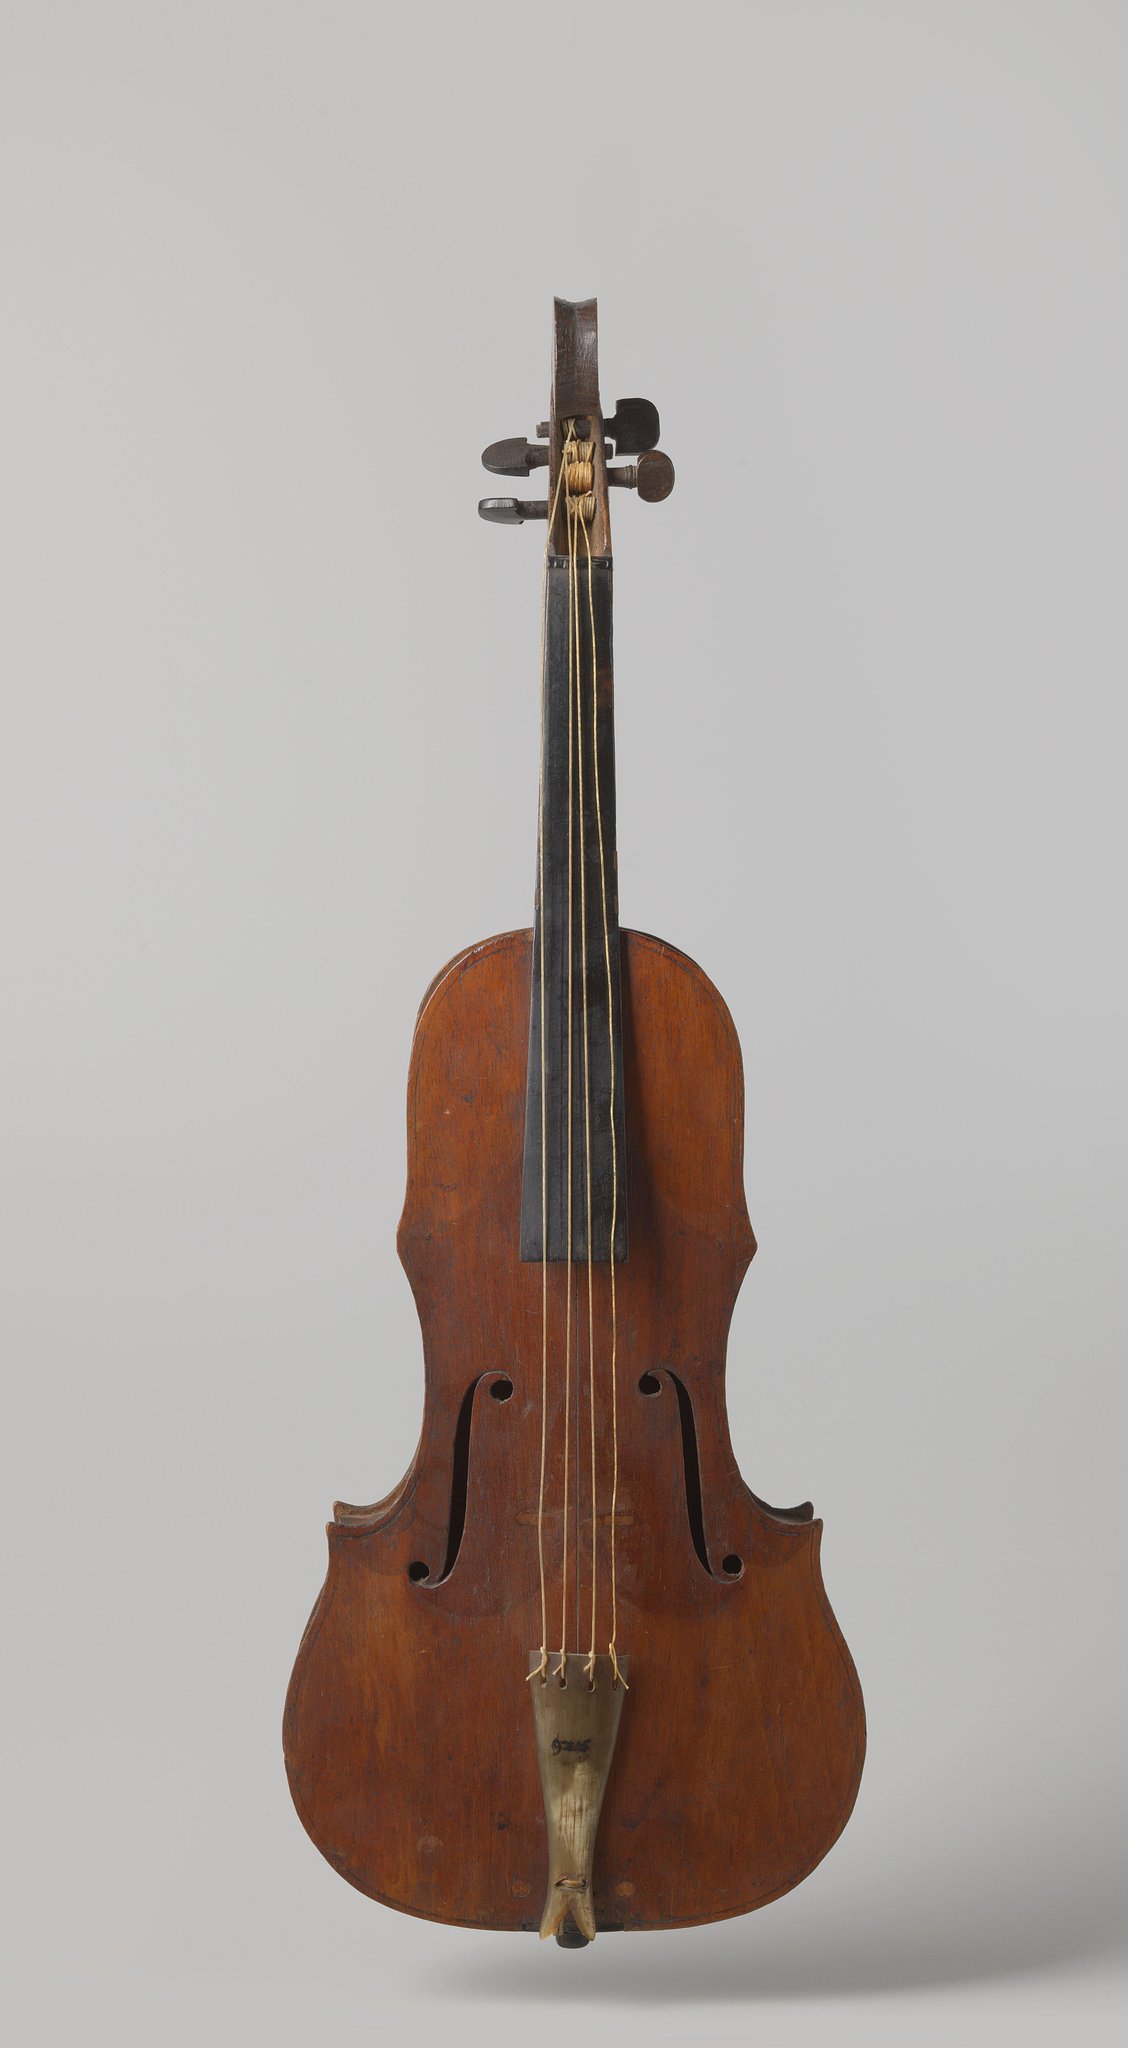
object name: bowed instrument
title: Violin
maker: Anonymous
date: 1700-1799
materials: wood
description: Viool van zonderlinge niet fraaie vorm. Op het achterblad een kasteel in reliëf, door het uitsparen bij het verdunnen van het blad gevormd. Eén der schroeven ontbreekt.